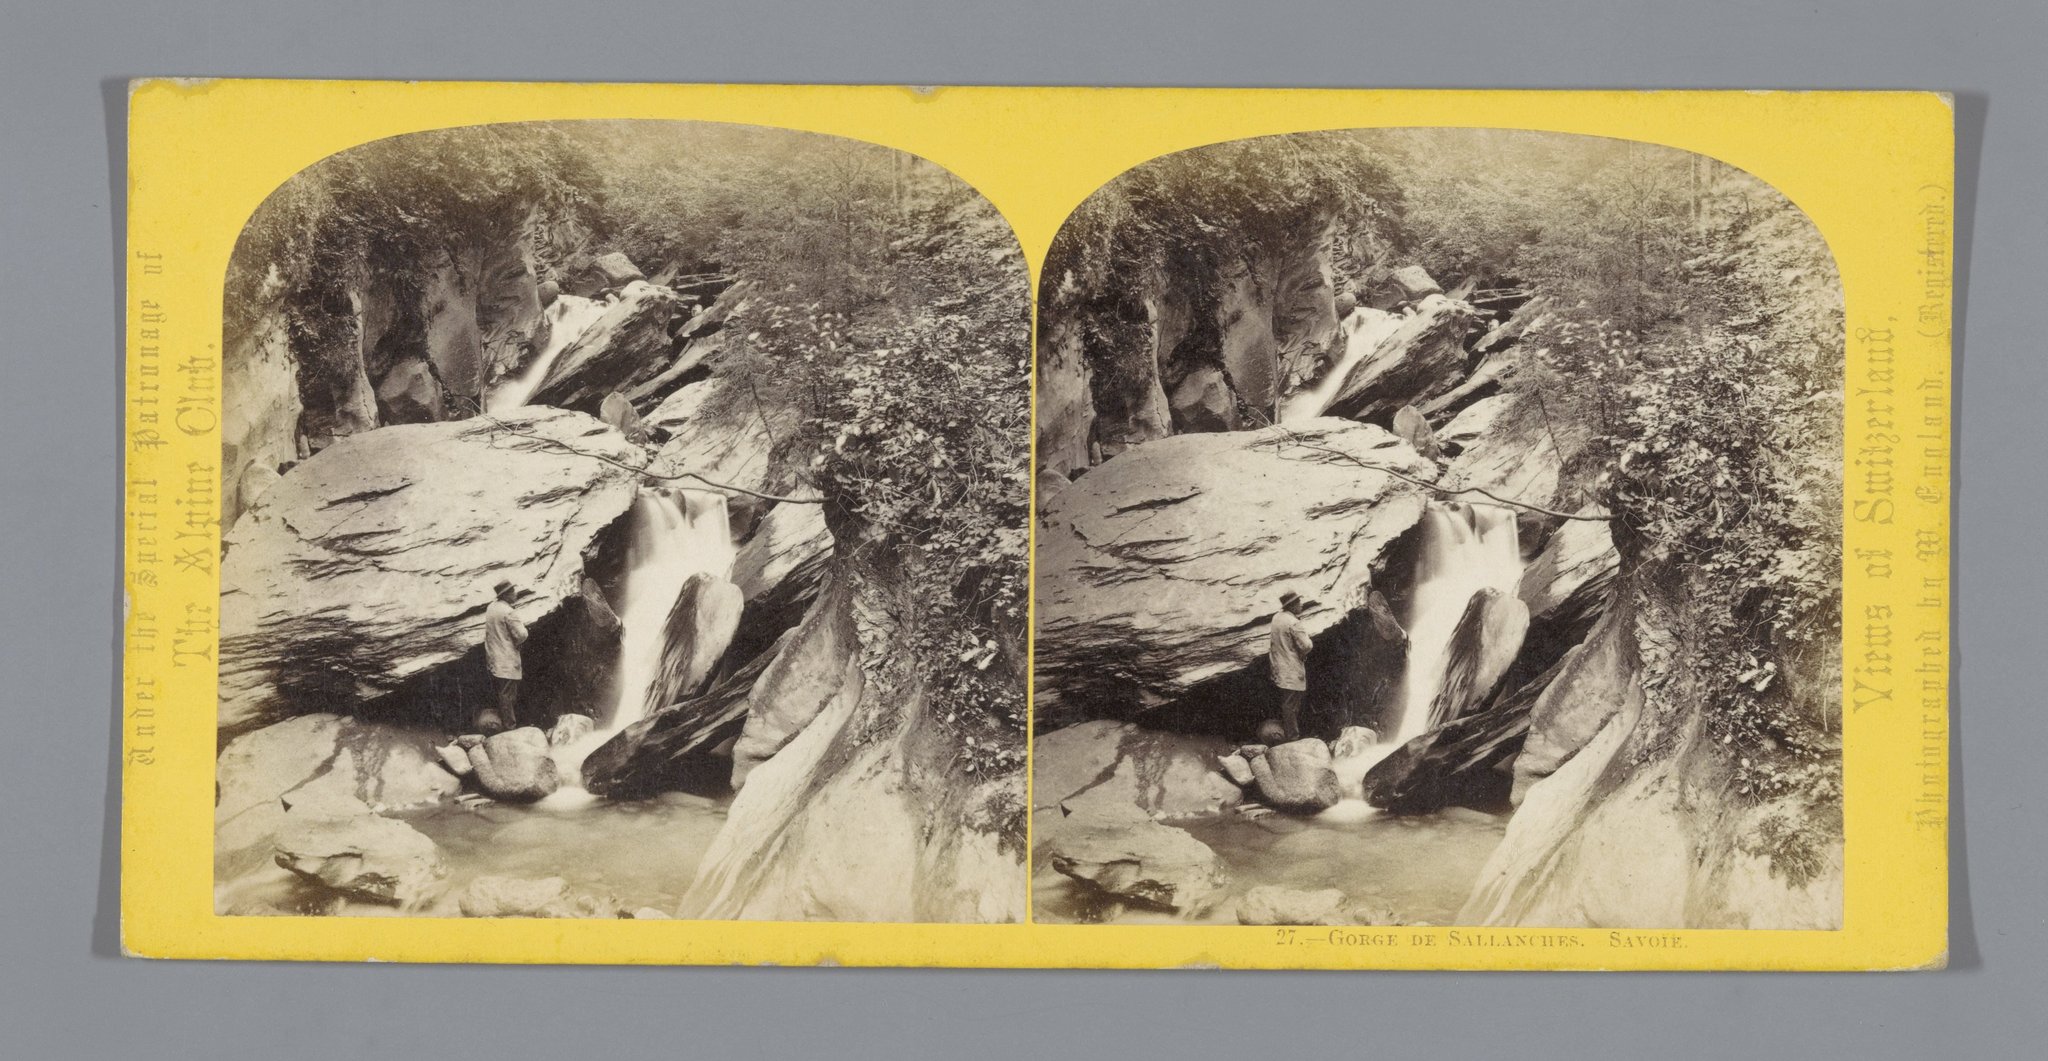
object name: stereograph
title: Gorge de Sallanches. Savoie.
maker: william england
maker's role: fotograaf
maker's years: 1816-1896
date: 1850-1880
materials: cardboard, photographic support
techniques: albumen print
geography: bonneville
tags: rapids, ravine, chasm, abyss, canyon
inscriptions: inscription: ‘Views of Switzerland, photographed by W. England. (Registered) Under the Special Patronage of the Alpine Club.’, number: ‘27.’